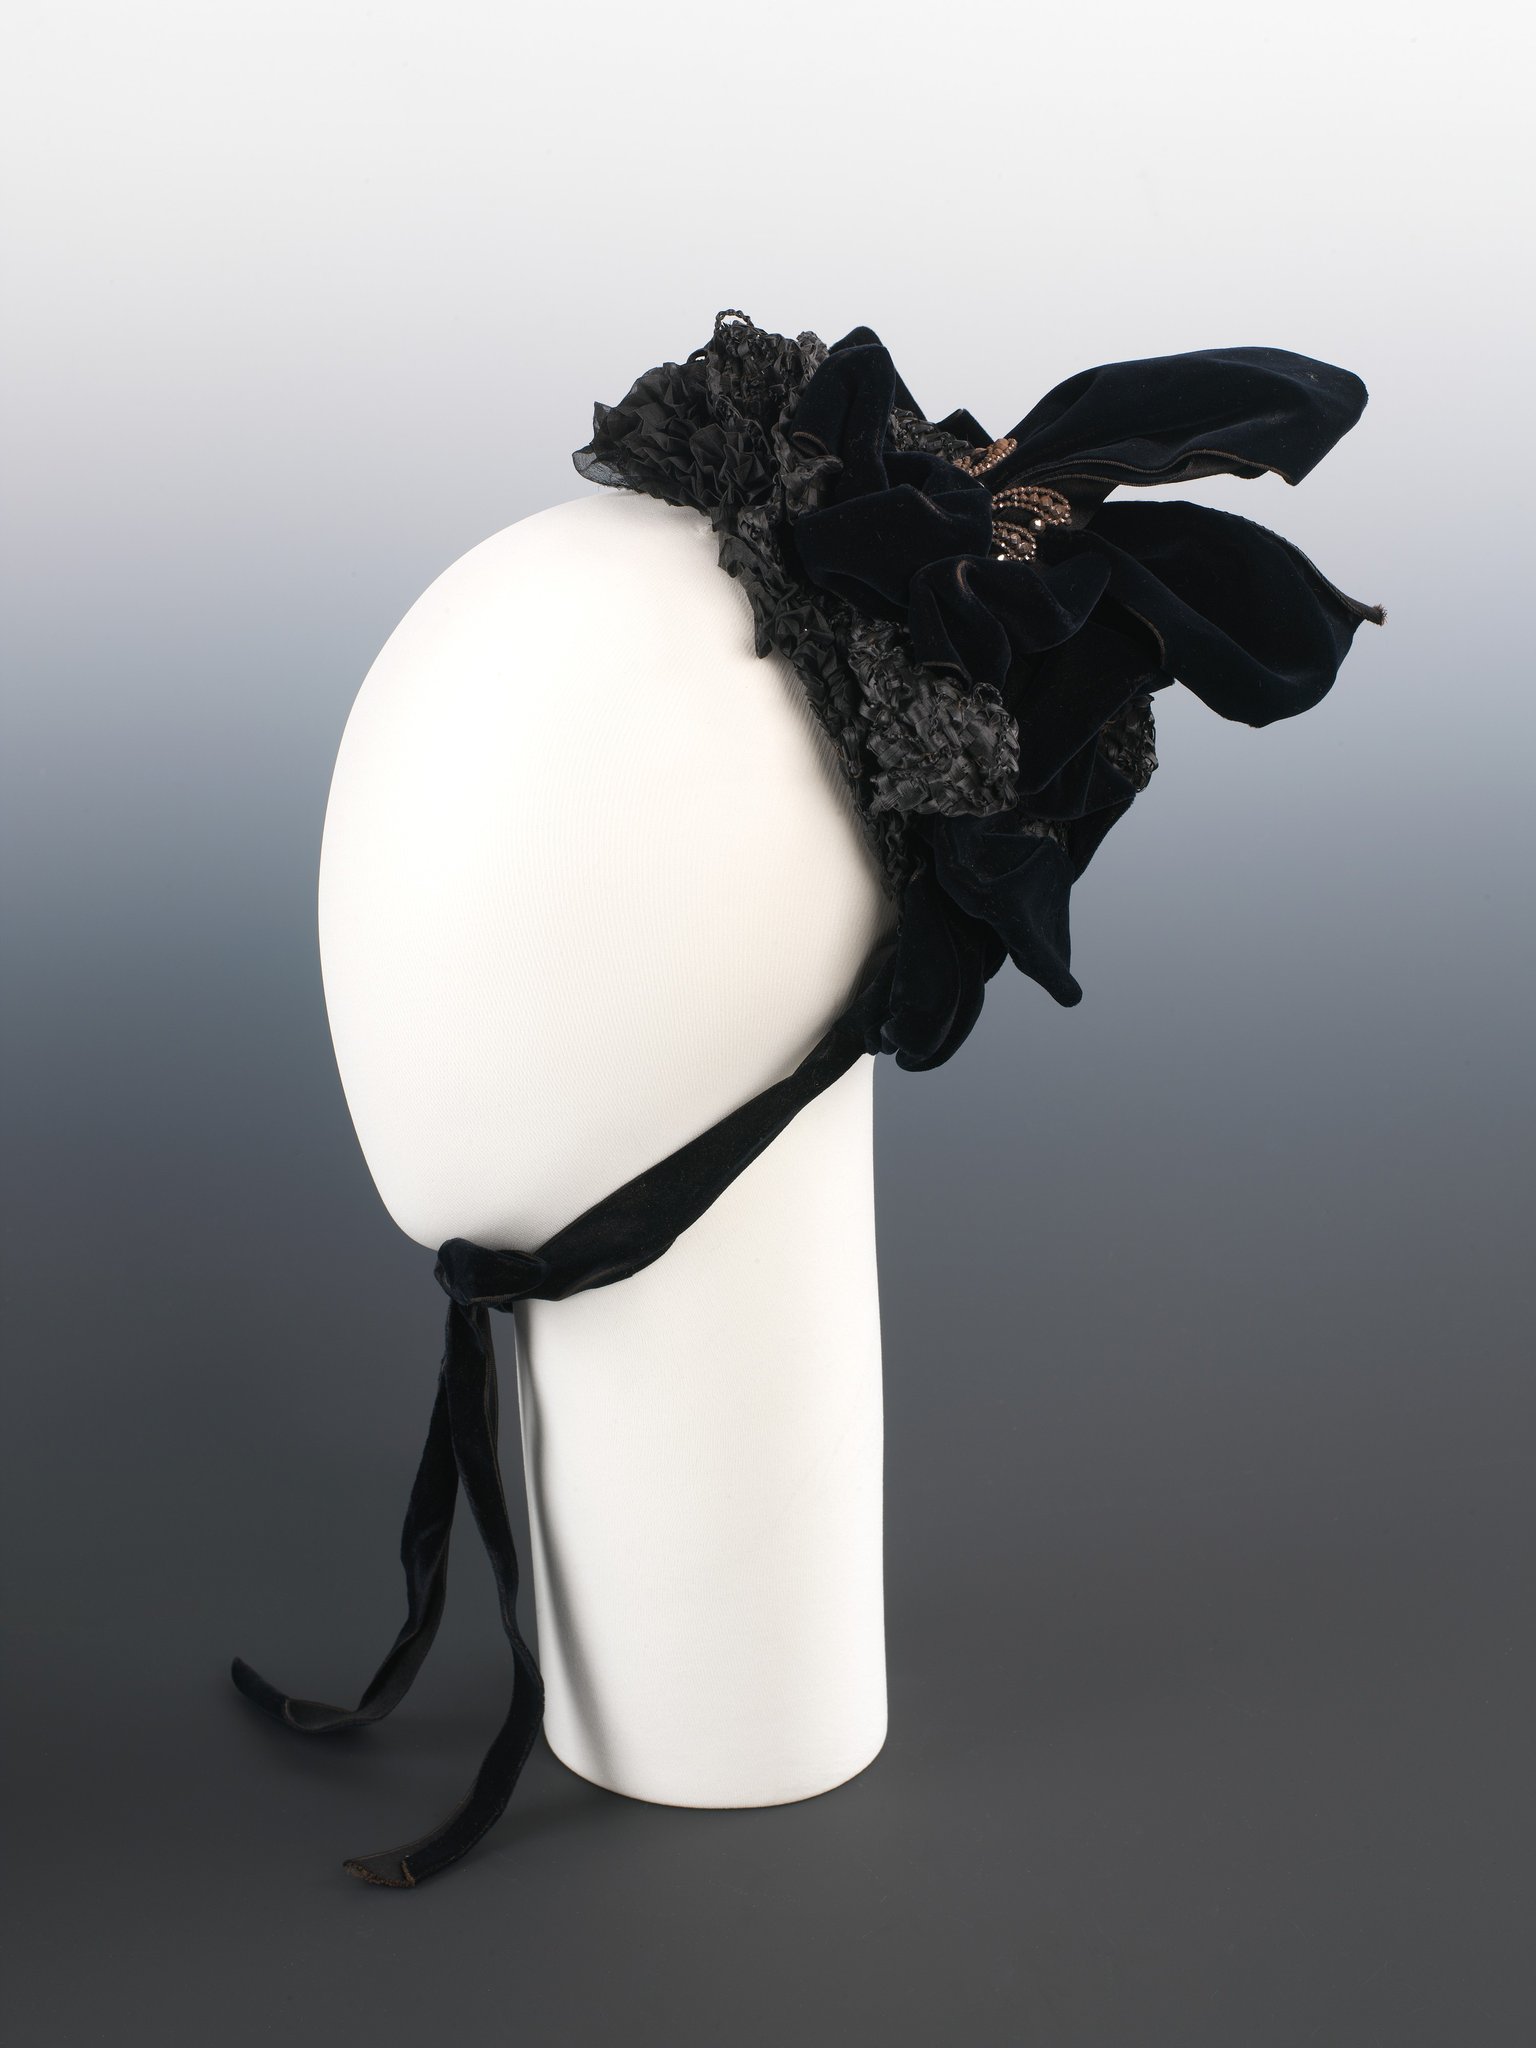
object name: evening bonnet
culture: american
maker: healy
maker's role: designer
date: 1892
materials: metal, silk, fiber